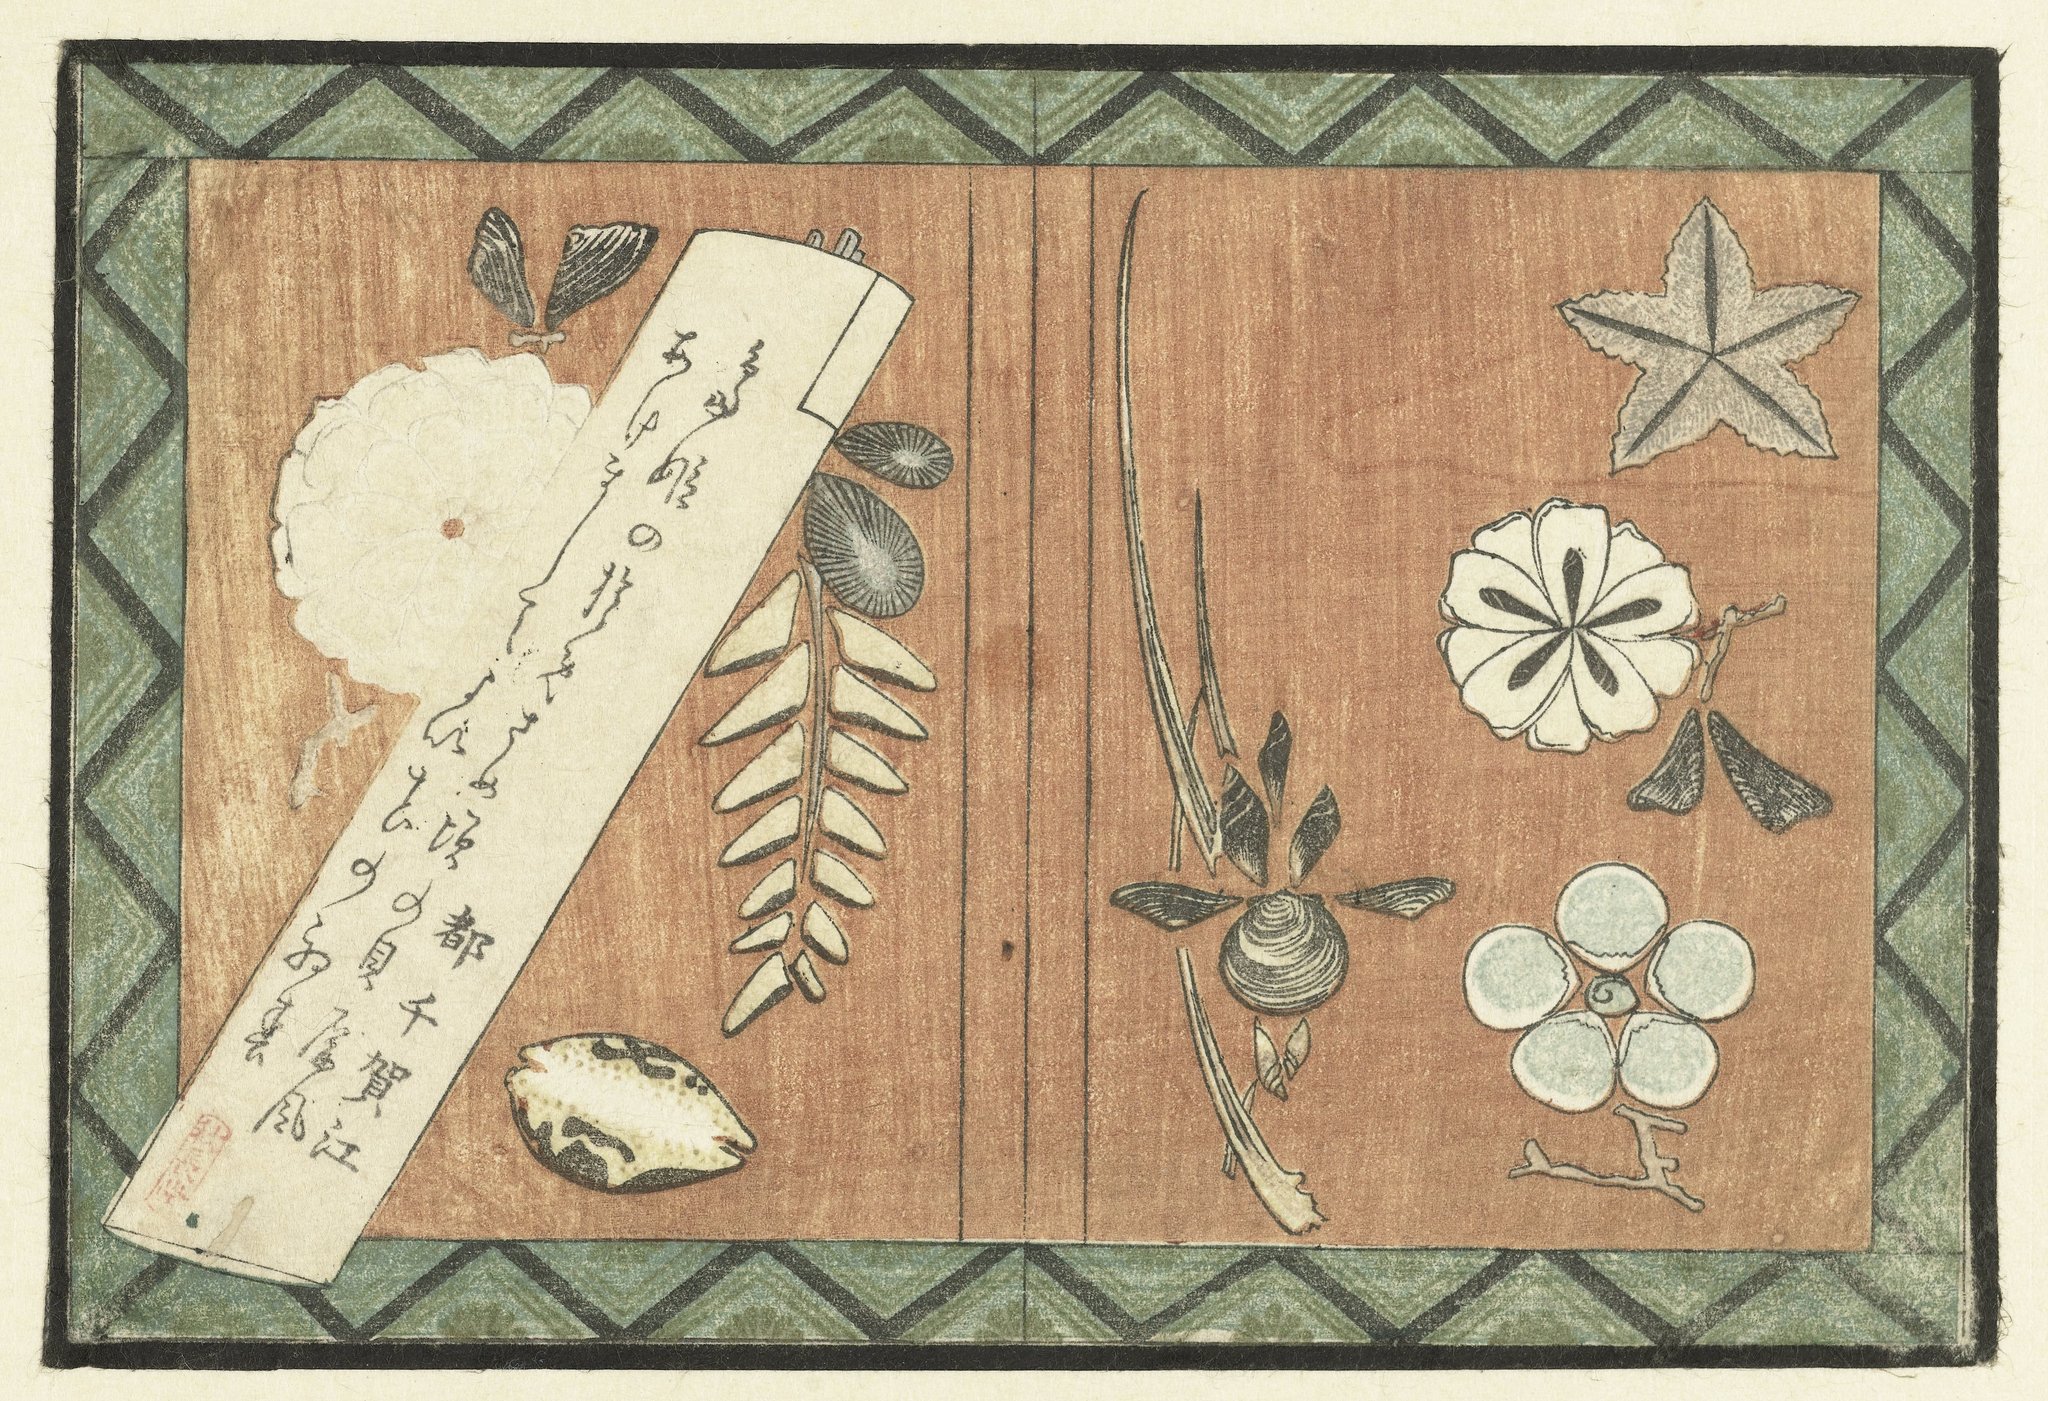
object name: egoyomi kalenderblad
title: A Painting Made of Shells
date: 1797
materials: paper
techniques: blind stamped, woodcut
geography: japan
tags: flowers, scallop, shell ~ ornament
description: Een surimono is een luxe uitgevoerde prent waarop beeld met één of meerdere gedichten gecombineerd is. Bij het drukken van een surimono werd vaak gebruik gemaakt van dikker papier, blinddruk en metaal pigmenten, zoals koper- en zilverpoeder. De prenten werden vaak in opdracht van dichters gemaakt en als exclusief geschenk aan vrienden en relaties gegeven. Een egoyomi is een kalender prent, waarop de aanduiding voor de maanden verstopt zit in het ontwerp. Vaak werden egoyomi net als surimono in eigen beheer uitgegeven en aan vrienden kado gedaan. In Japan gebruikte men tot 1873 een maankalender, waarbij de volgorde van de lange en de korte maanden jaarlijks varieerde. Omdat er maar een klein aantal uitgevers kalenders mocht maken, waren particulier uitgeven kalender prenten tegen de regels van de overheid. Om deze regels te omzeilen werden de kalendergegevens verstopt in het prentontwerp.